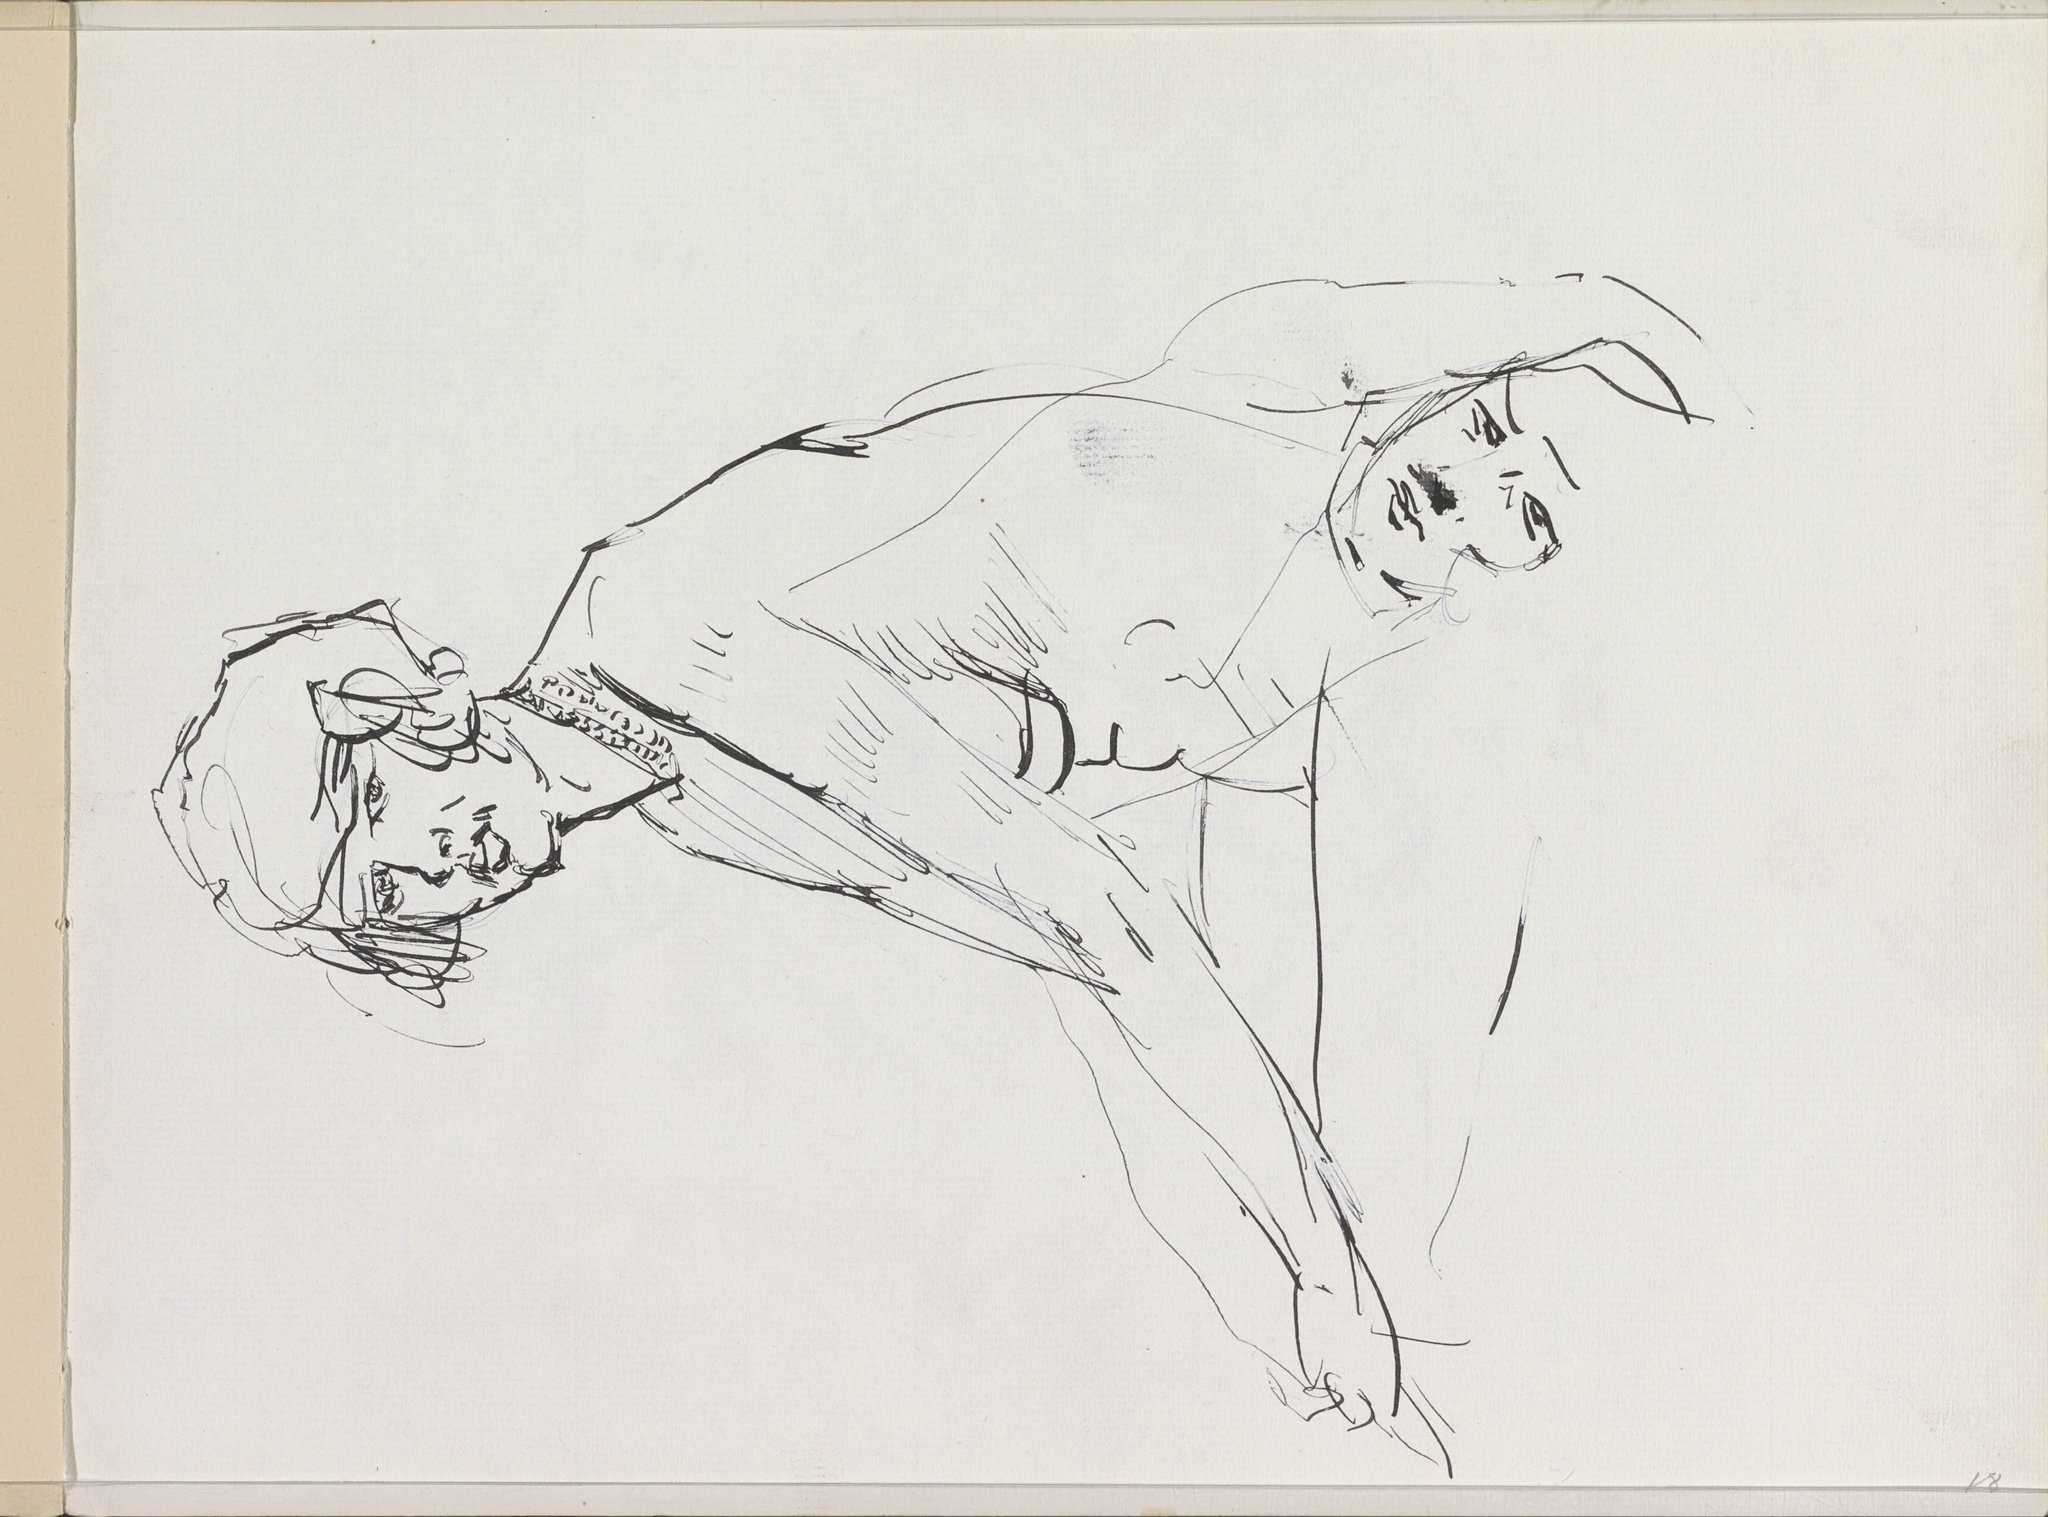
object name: sketchbook leaf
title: Zittend vrouwelijk naakt en een gezicht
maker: isaac israels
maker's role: draughtsman, painter, print maker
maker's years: 1865-1934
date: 1875-1934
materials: ink, paper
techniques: pen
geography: the hague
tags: sitting figure - aa - female human figure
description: Blad 18 recto uit schetsboek IV met 27 bladen.